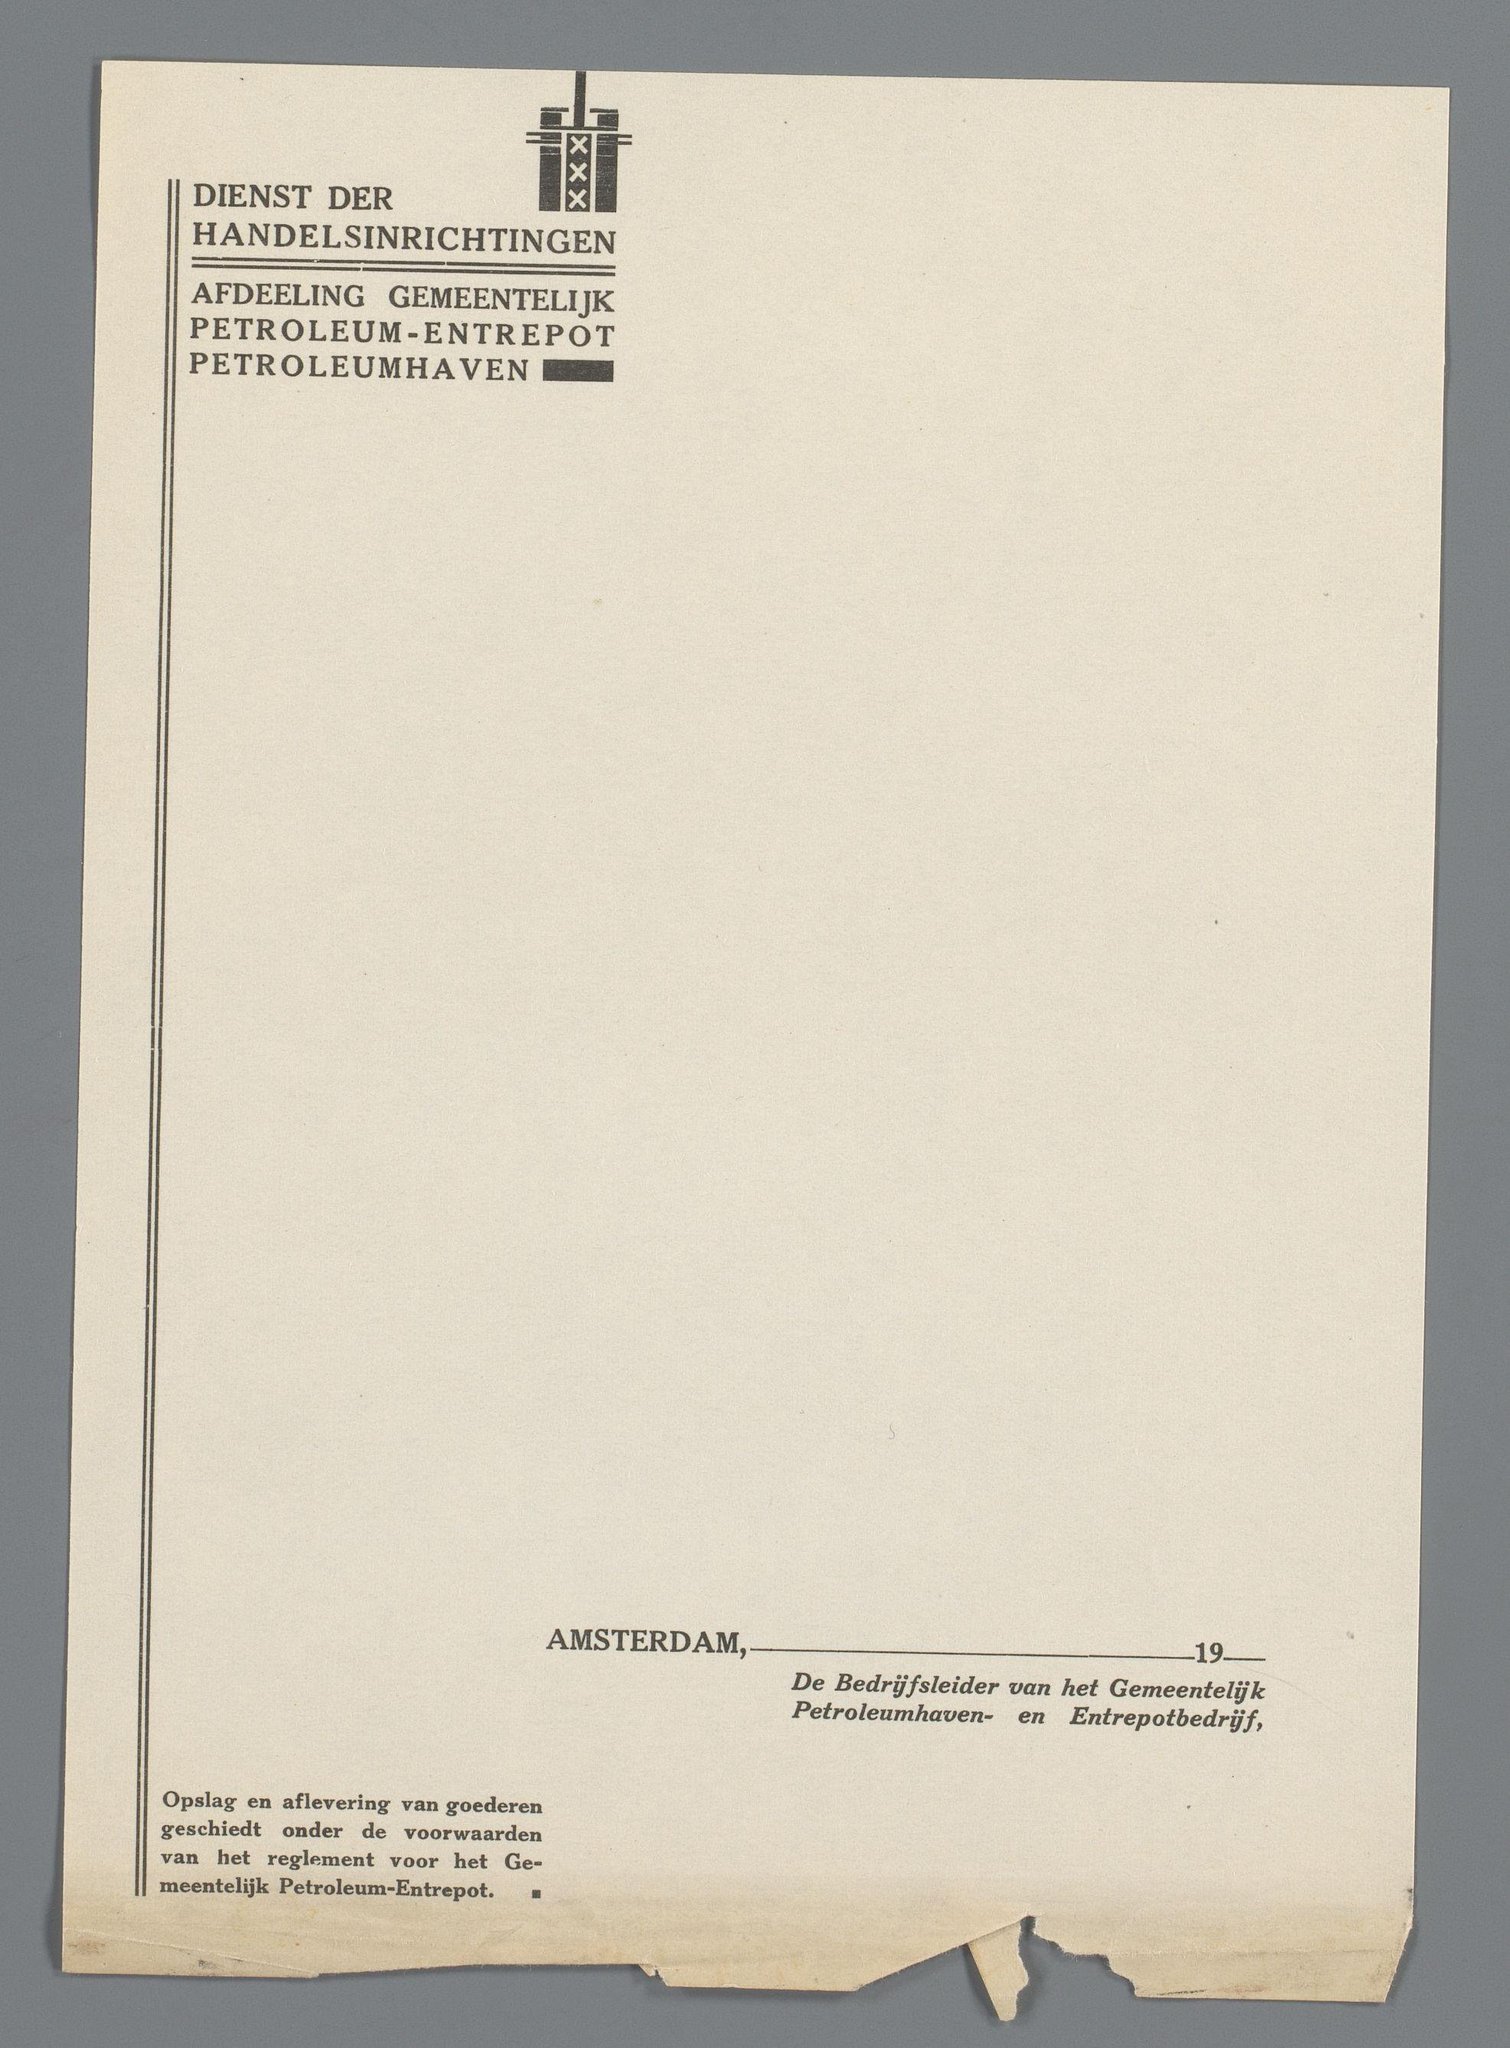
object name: photomechanical print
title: Briefpapier van de Dienst der Handelsinrichtingen / Afdeeling Gemeentelijk petroleum-entrepot petroleumhaven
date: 1930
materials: paper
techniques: printing block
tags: amsterdam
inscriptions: collector's mark: Lugt 2228